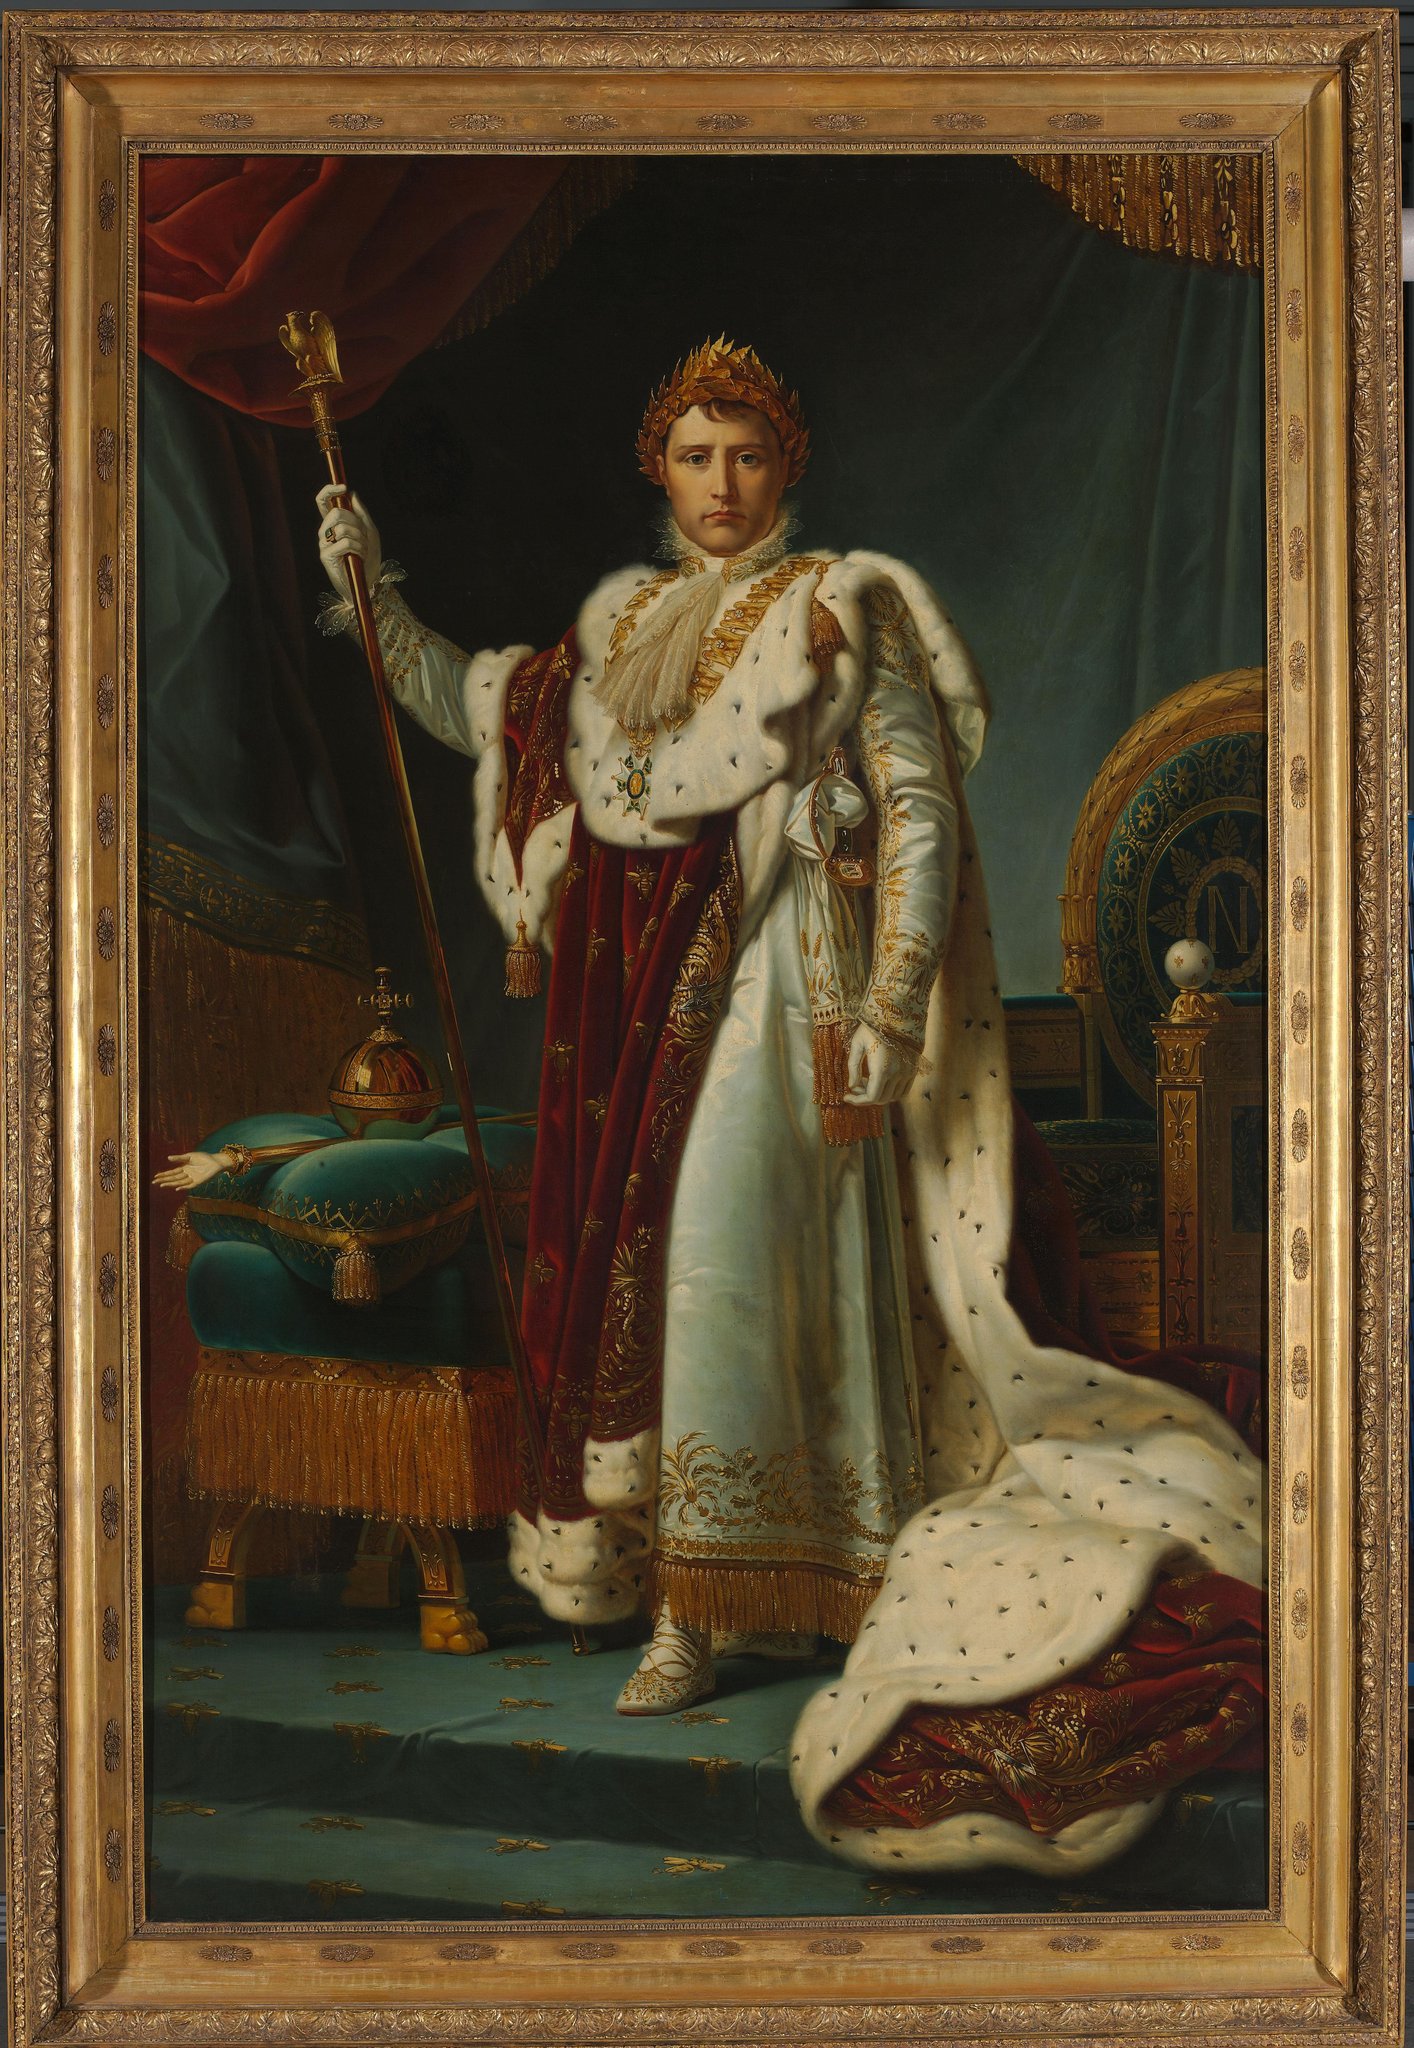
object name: painting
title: Portrait of Emperor Napoleon I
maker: françois gérard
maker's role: painter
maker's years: 1770-1837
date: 1805-1815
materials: canvas, oil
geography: paris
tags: napoleon i (emperor of the french), insignia and symbols of sovereignty (crown, diadem, sceptre, orb, seal, standard, cloak, pectoral), france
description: After having seized power through a coup d’état in 1799, General Napoleon proclaimed himself emperor in 1804. In the meanwhile, he conquered large parts of Europe. The year 1812 was a turning point. His invasion of Russia failed and his forces lost the Battle of the Nations near Leipzig. In 1814 Napoleon was exiled to the island of Elba. He escaped, but was definitively defeated 100 days later at the Battle of Waterloo.